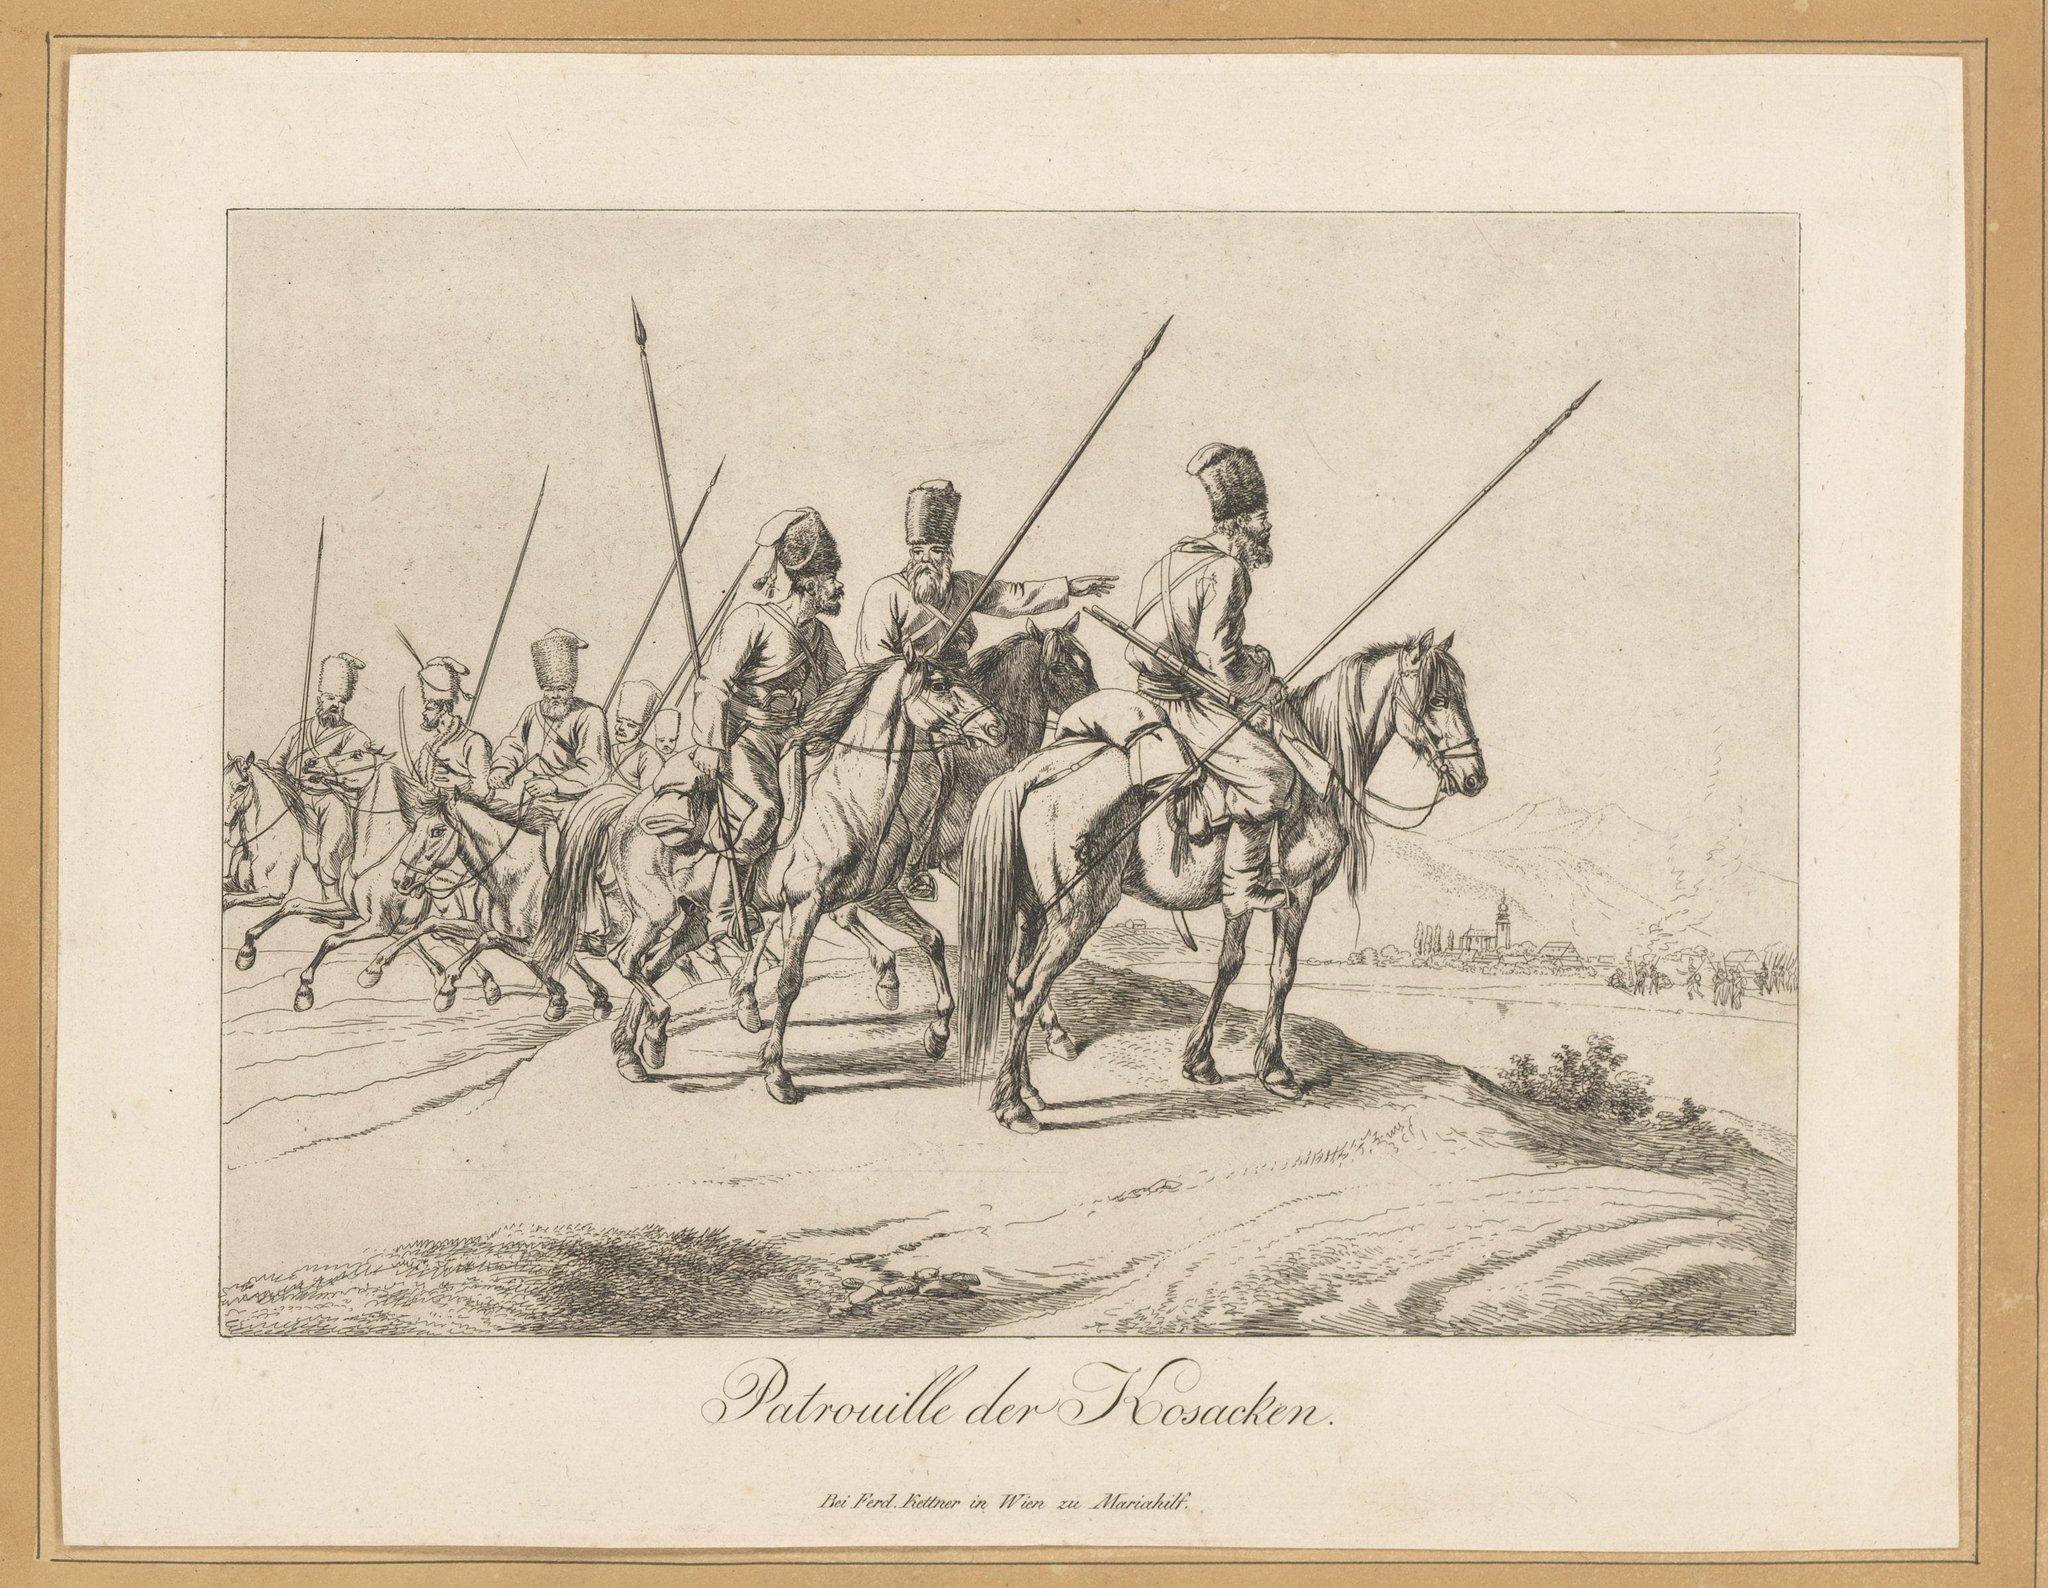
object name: print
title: Kozakken te paard op patrouille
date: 1808-1814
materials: paper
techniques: etching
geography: vienna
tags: riding a horse, ass, or mule; rider, horseman, guard duty, keeping sentry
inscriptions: collector's mark: Lugt 2228, collector's mark: Lugt 2760